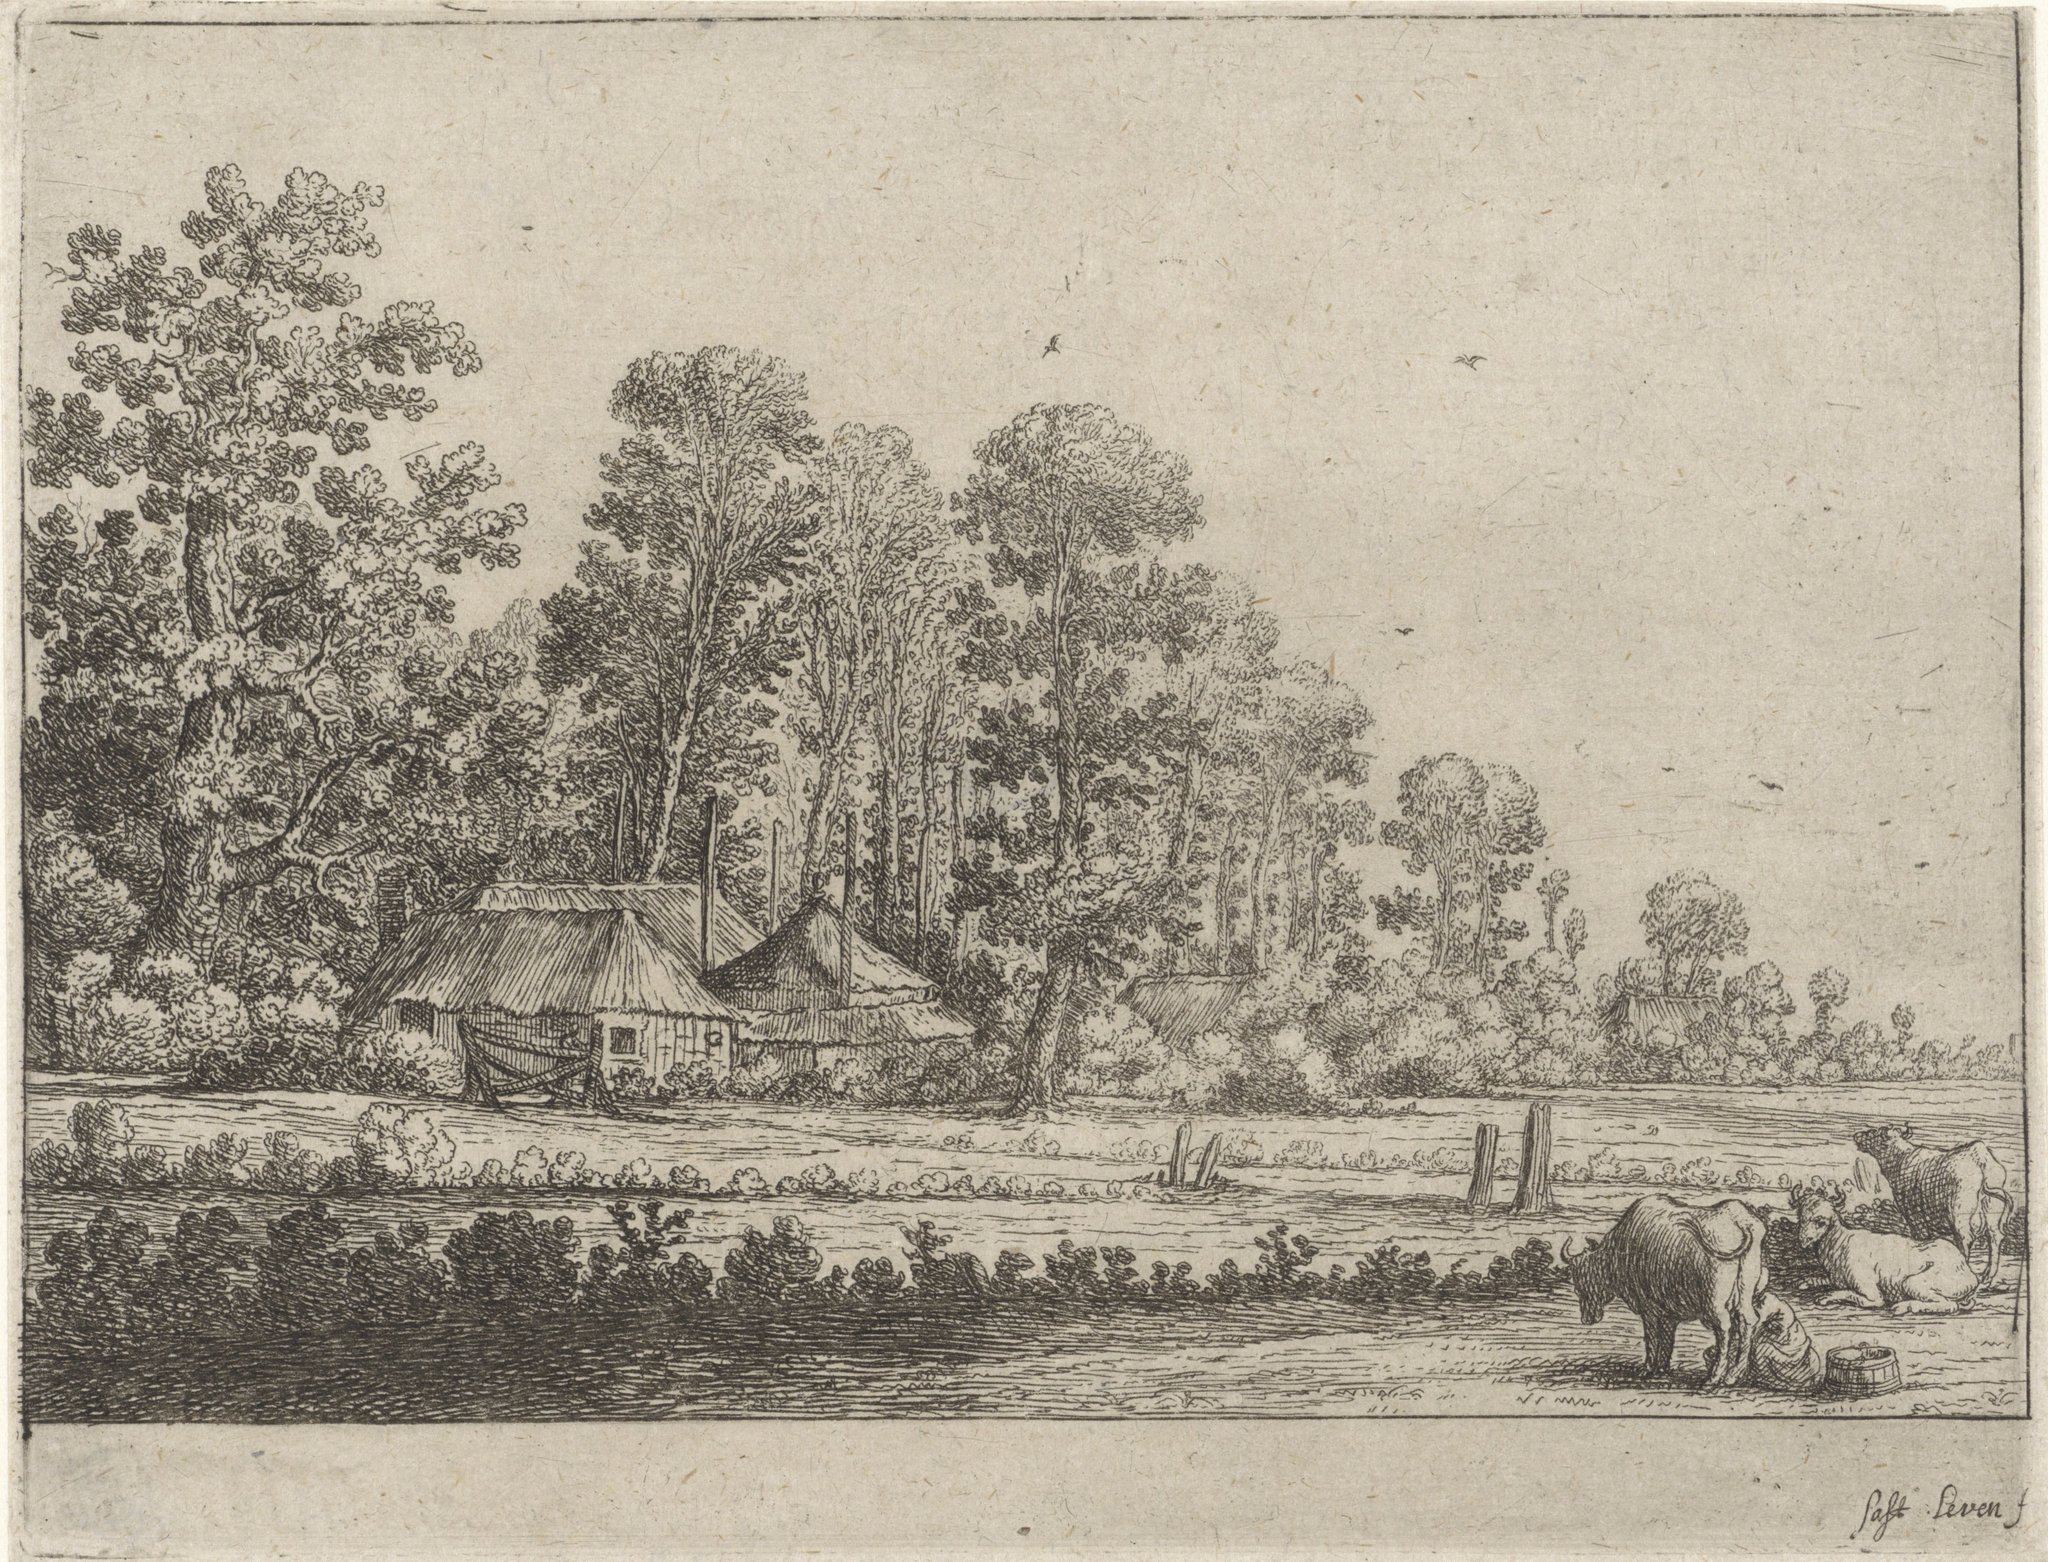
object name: print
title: Boerderij met koeienmelkster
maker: herman saftleven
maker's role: draughtsman, painter, print maker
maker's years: 1609-1685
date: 1626-1685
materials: paper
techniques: etching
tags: cow, meadow, pasture, farm or solitary house in landscape, milking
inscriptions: collector's mark: Lugt 796, collector's mark: Lugt 2110, collector's mark: Lugt 2760, collector's mark: Lugt 2228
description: Gezicht op een vlak landschap met op de voorgrond een weide met drie koeien, waarvan er één gemolken wordt. Op de achtergrond liggen boerderijen aan de bosrand.